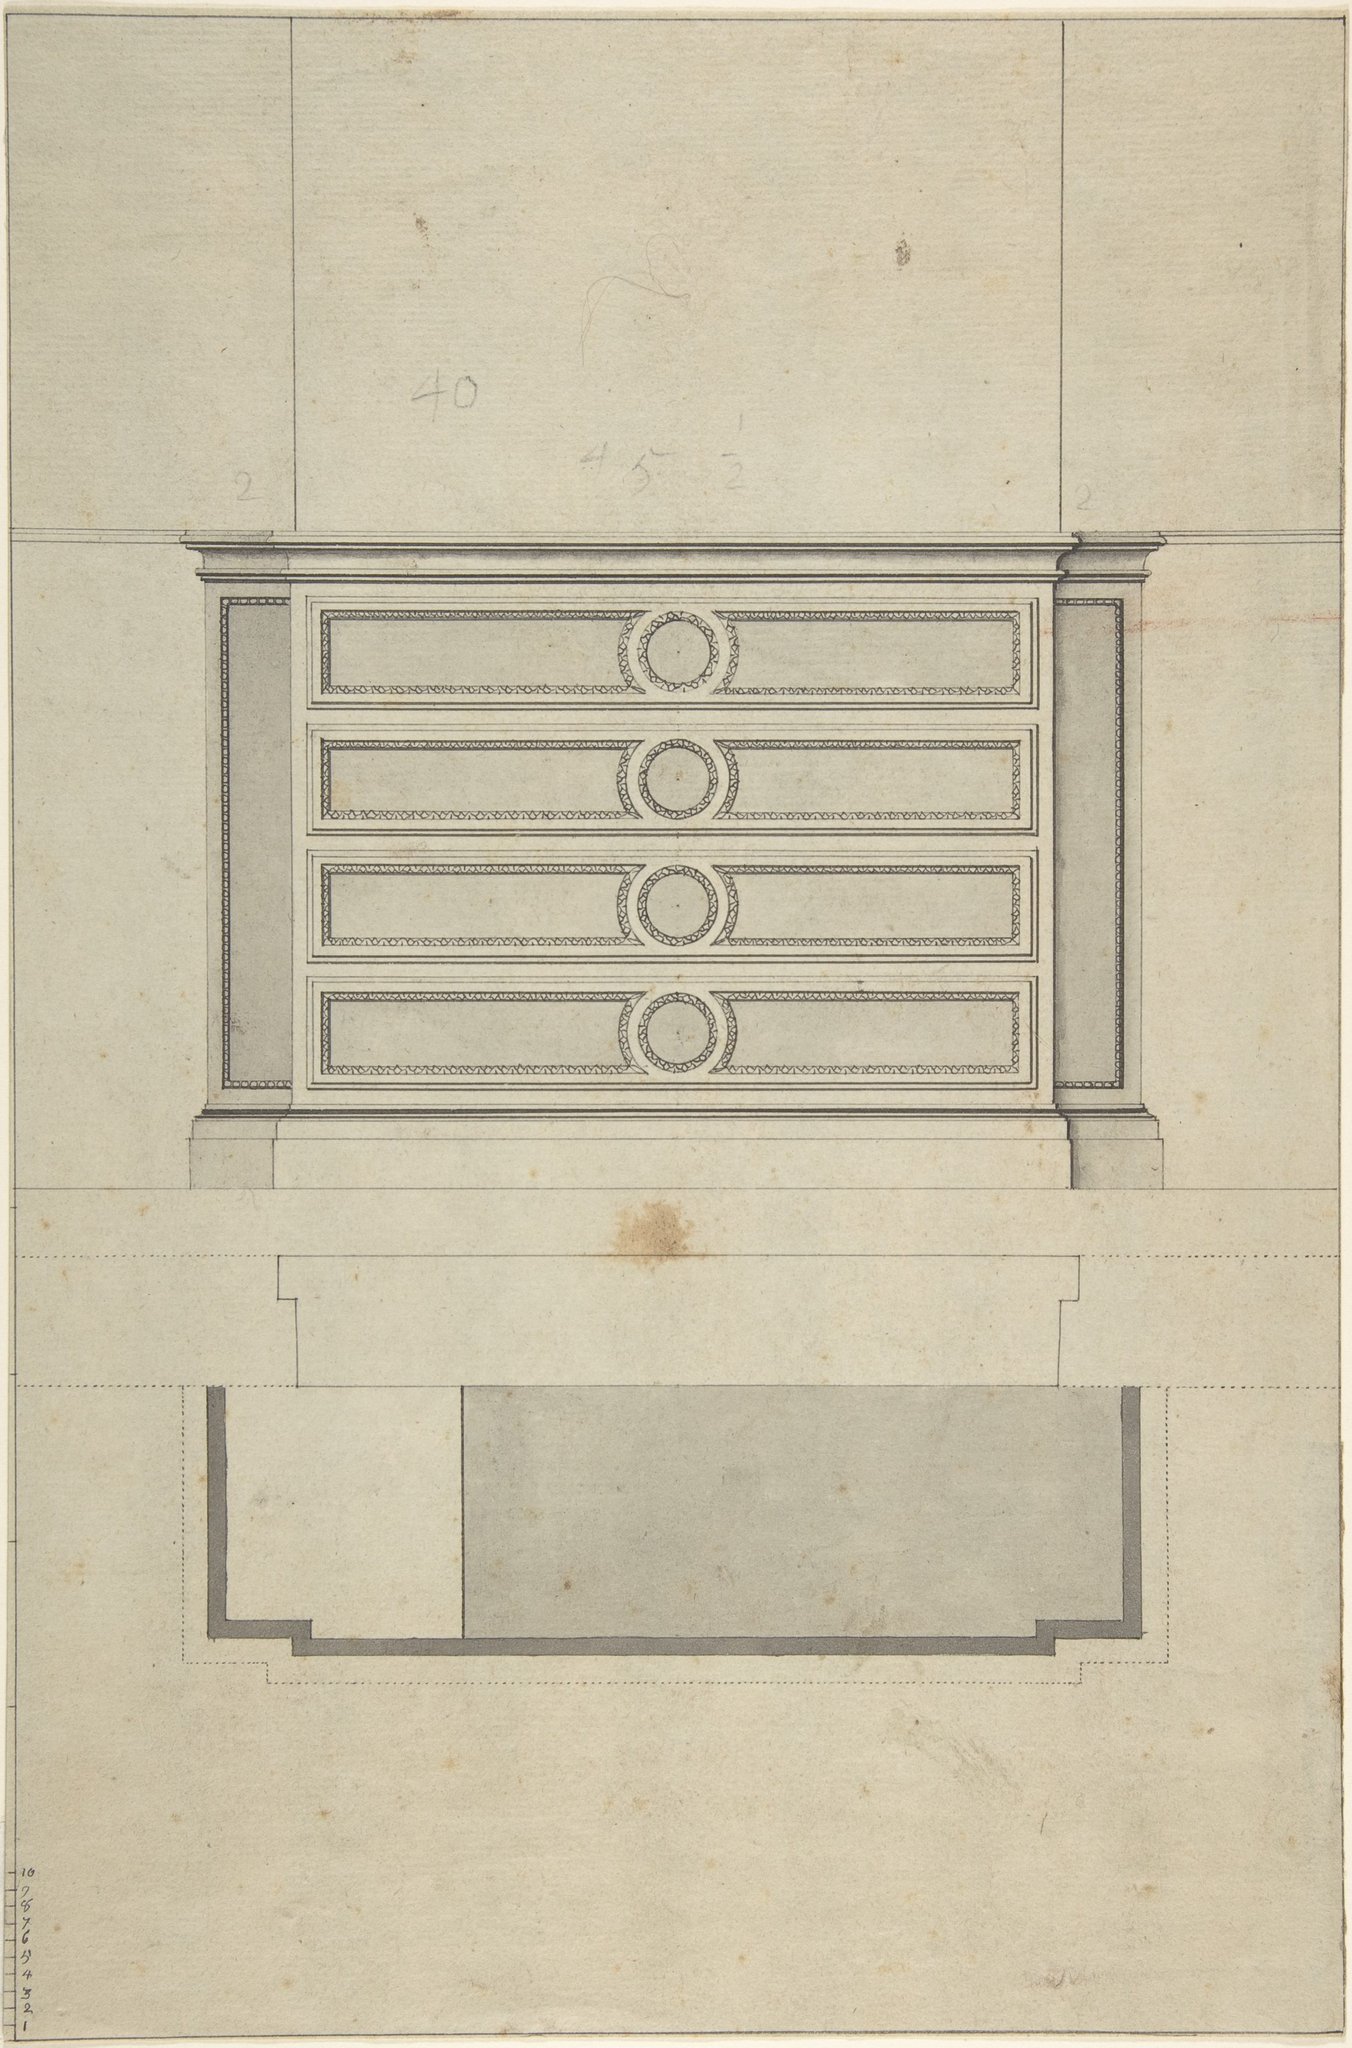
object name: drawing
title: Design for Furniture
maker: anonymous, french, 19th century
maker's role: artist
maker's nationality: french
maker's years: 1800-1900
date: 1801-1900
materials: ink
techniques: brush, pen, wash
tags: furniture